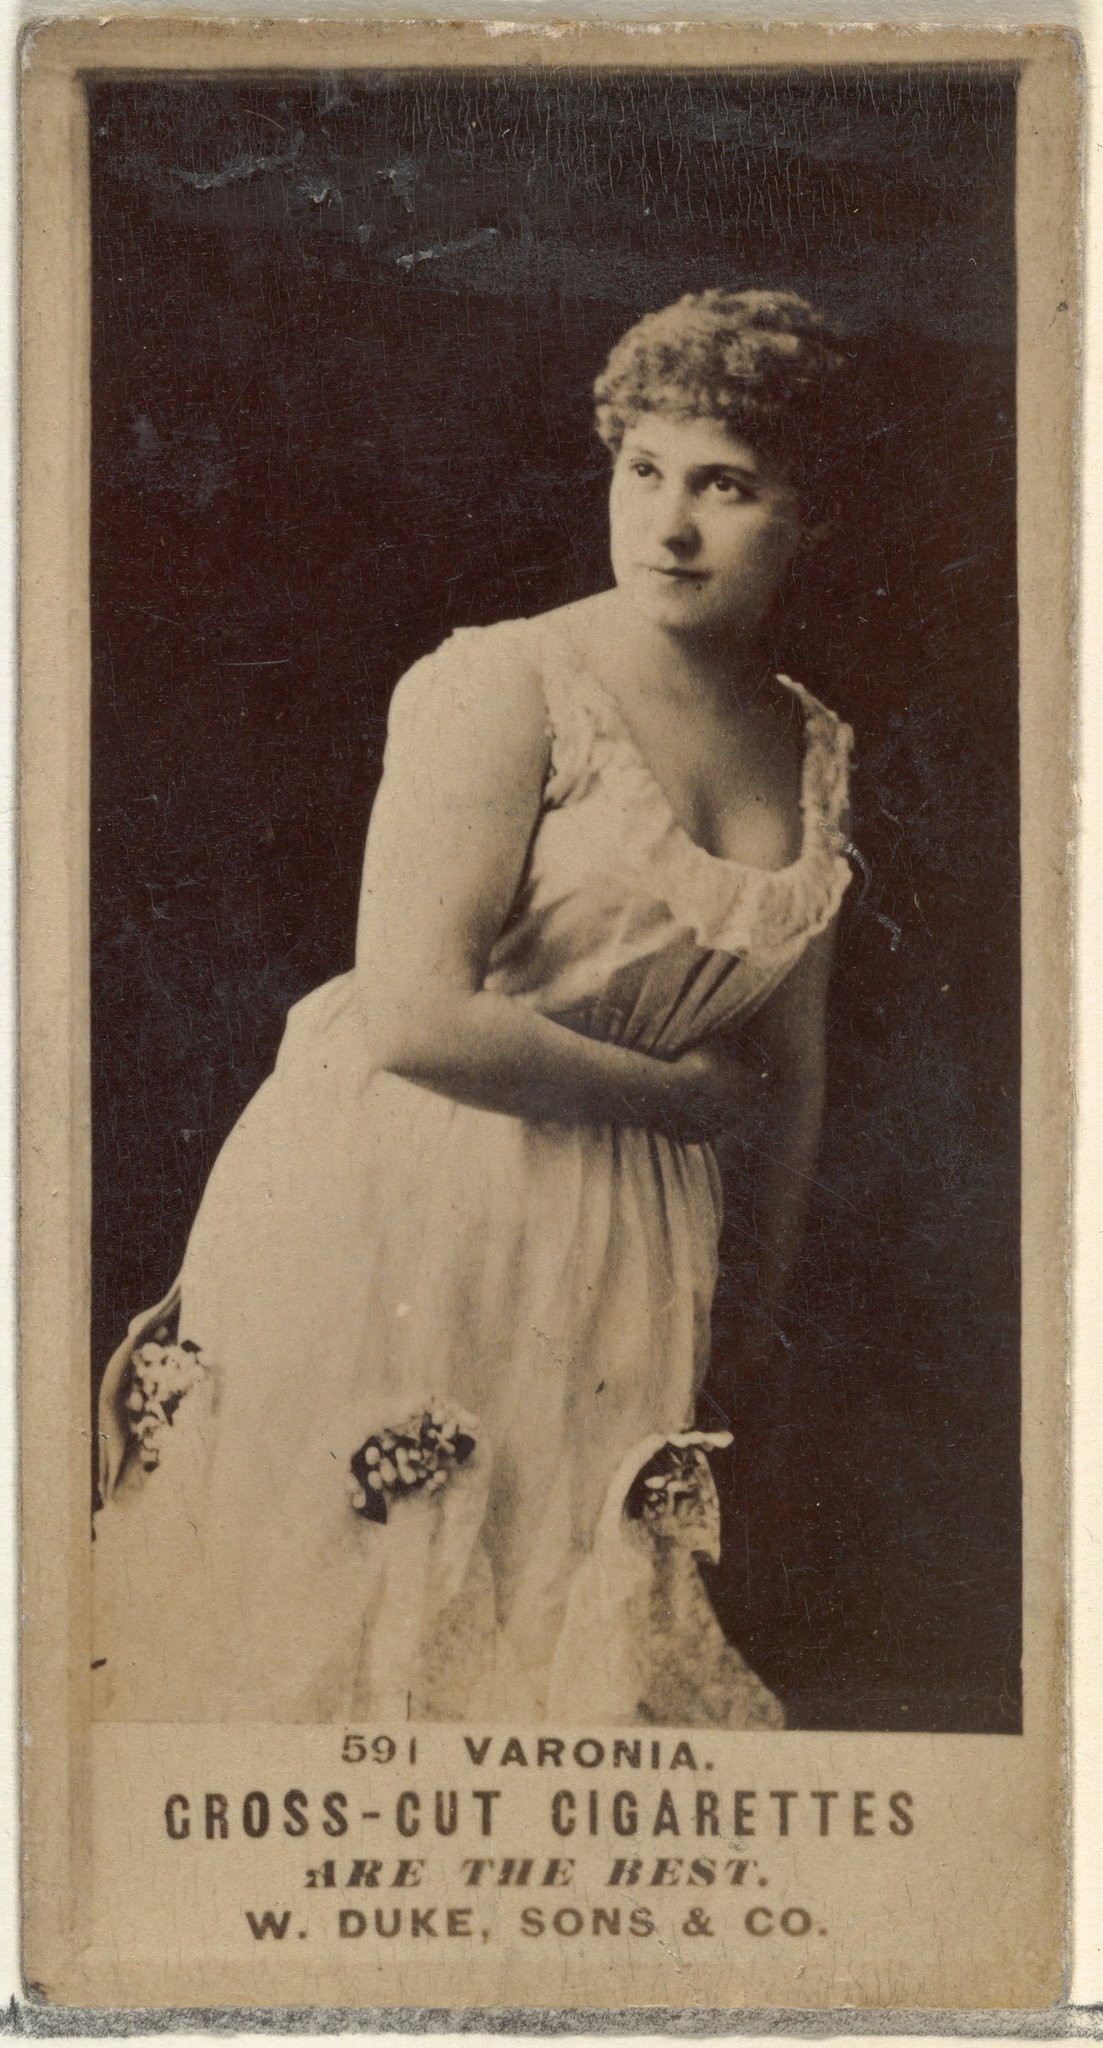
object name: photograph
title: Card Number 591, Varonia, from the Actors and Actresses series (N145-3) issued by Duke Sons & Co. to promote Cross Cut Cigarettes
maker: w. duke, sons & co.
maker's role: publisher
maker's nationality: american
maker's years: 1870-1920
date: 1880-1889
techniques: albumen silver print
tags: portraits,women,actresses